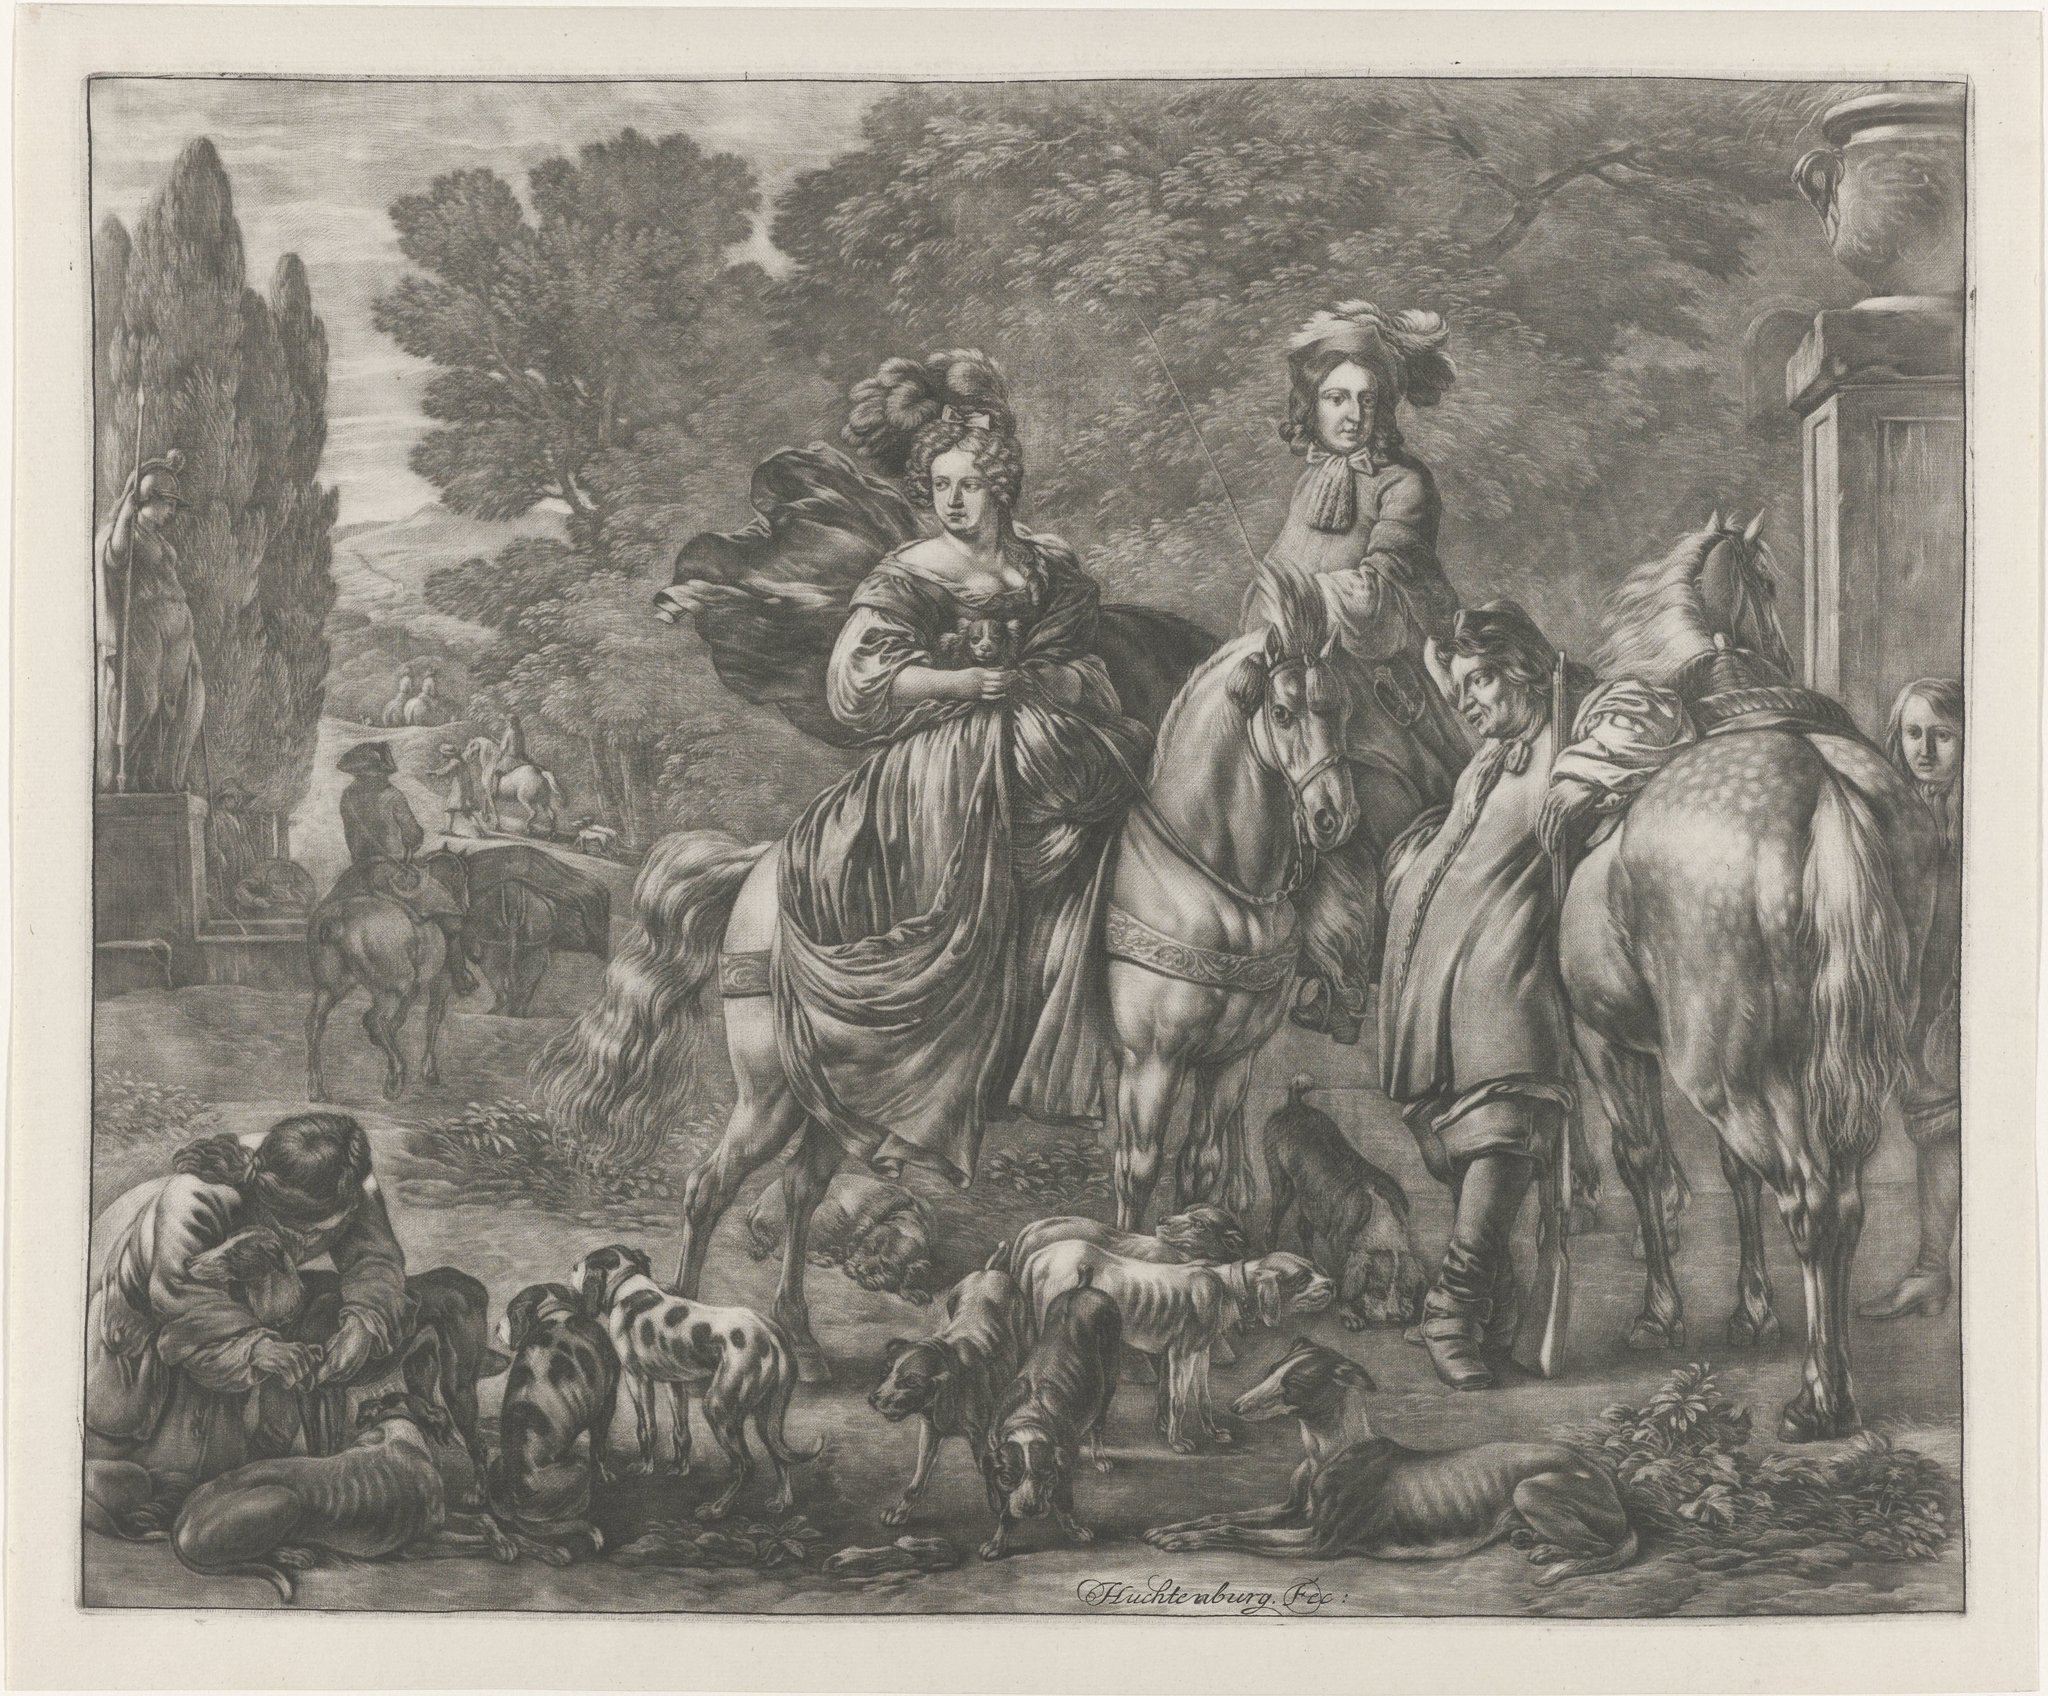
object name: print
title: Koning Willem III en Maria II Stuart rusten tijdens de jacht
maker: jan van huchtenburg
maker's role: draughtsman, painter, print maker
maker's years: 1647-1733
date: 1688-1733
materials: paper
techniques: engraving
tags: the hague, william iii (prince of orange and king of england, scotland, and ireland), maria ii stuart (koningin van engeland, schotland en ierland), hunting, chase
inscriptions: collector's mark: Lugt 240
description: Willem III, prins van Oranje-Nassau en Maria II Stuart rusten tijdens de jacht. Om hen heen verschillende jagers, honden en paarden. Op de achtergrond lest een man zijn dorst bij een fontein.